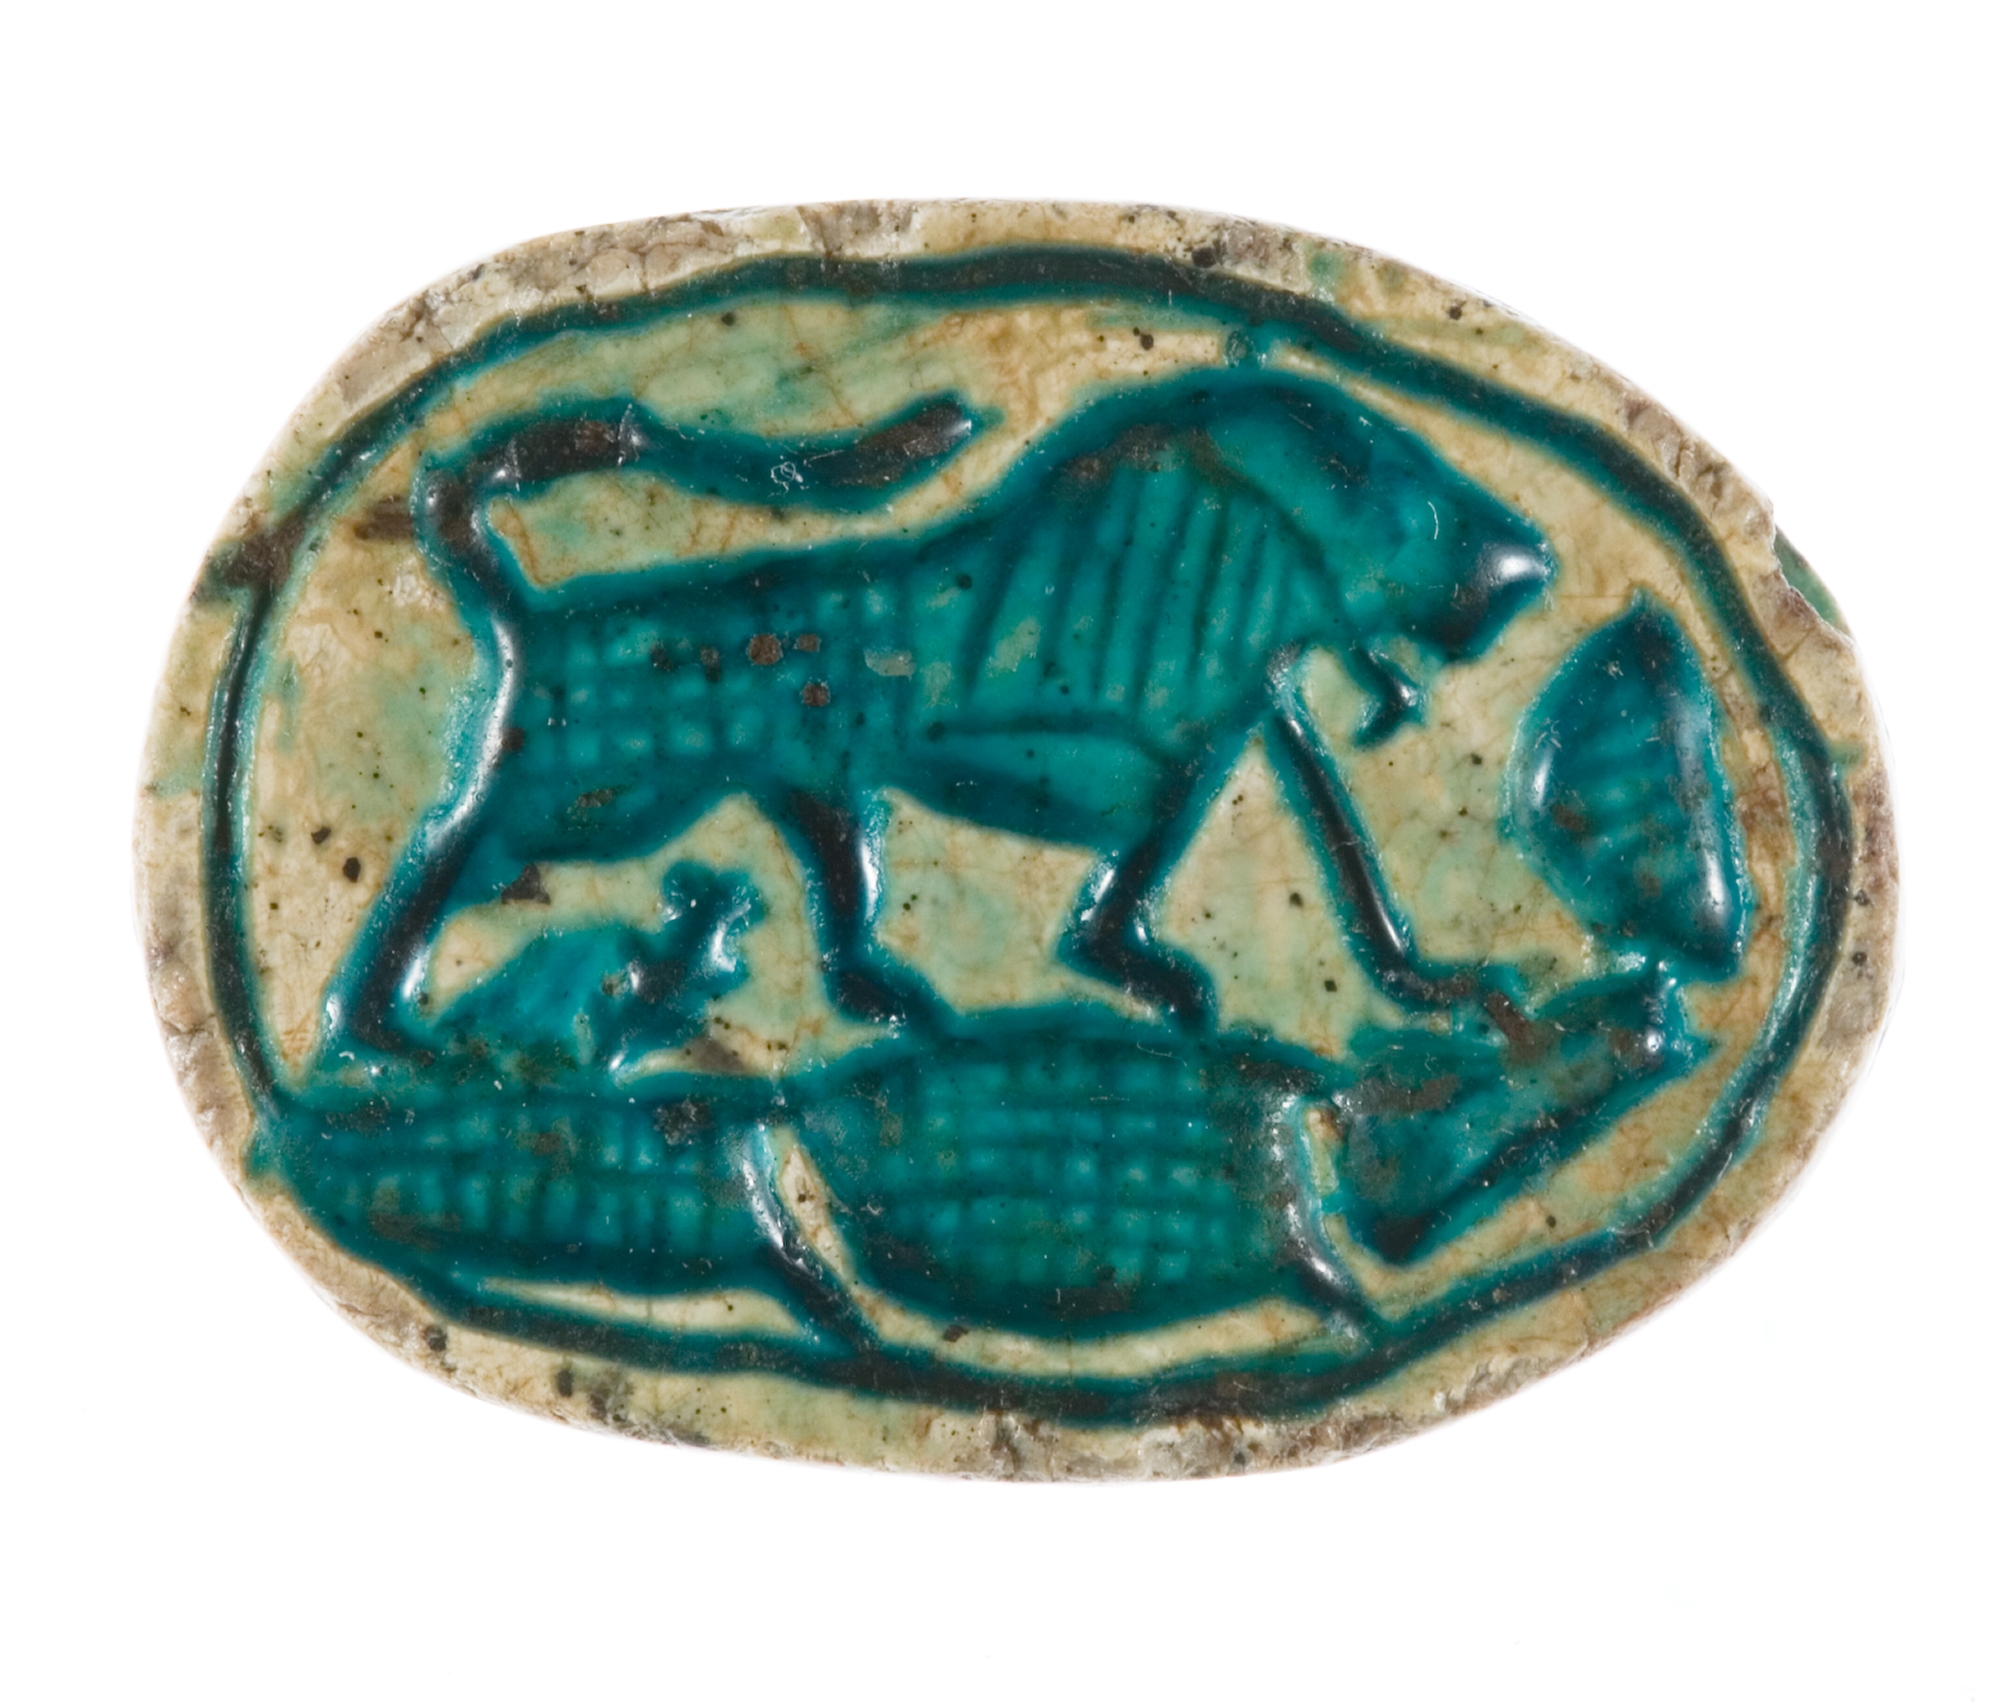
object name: scarab, crocodile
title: Canaanite Scarab with a Lion over a Crocodile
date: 1600-1500 BCE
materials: stone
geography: canaan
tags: crocodiles,scarabs,lions